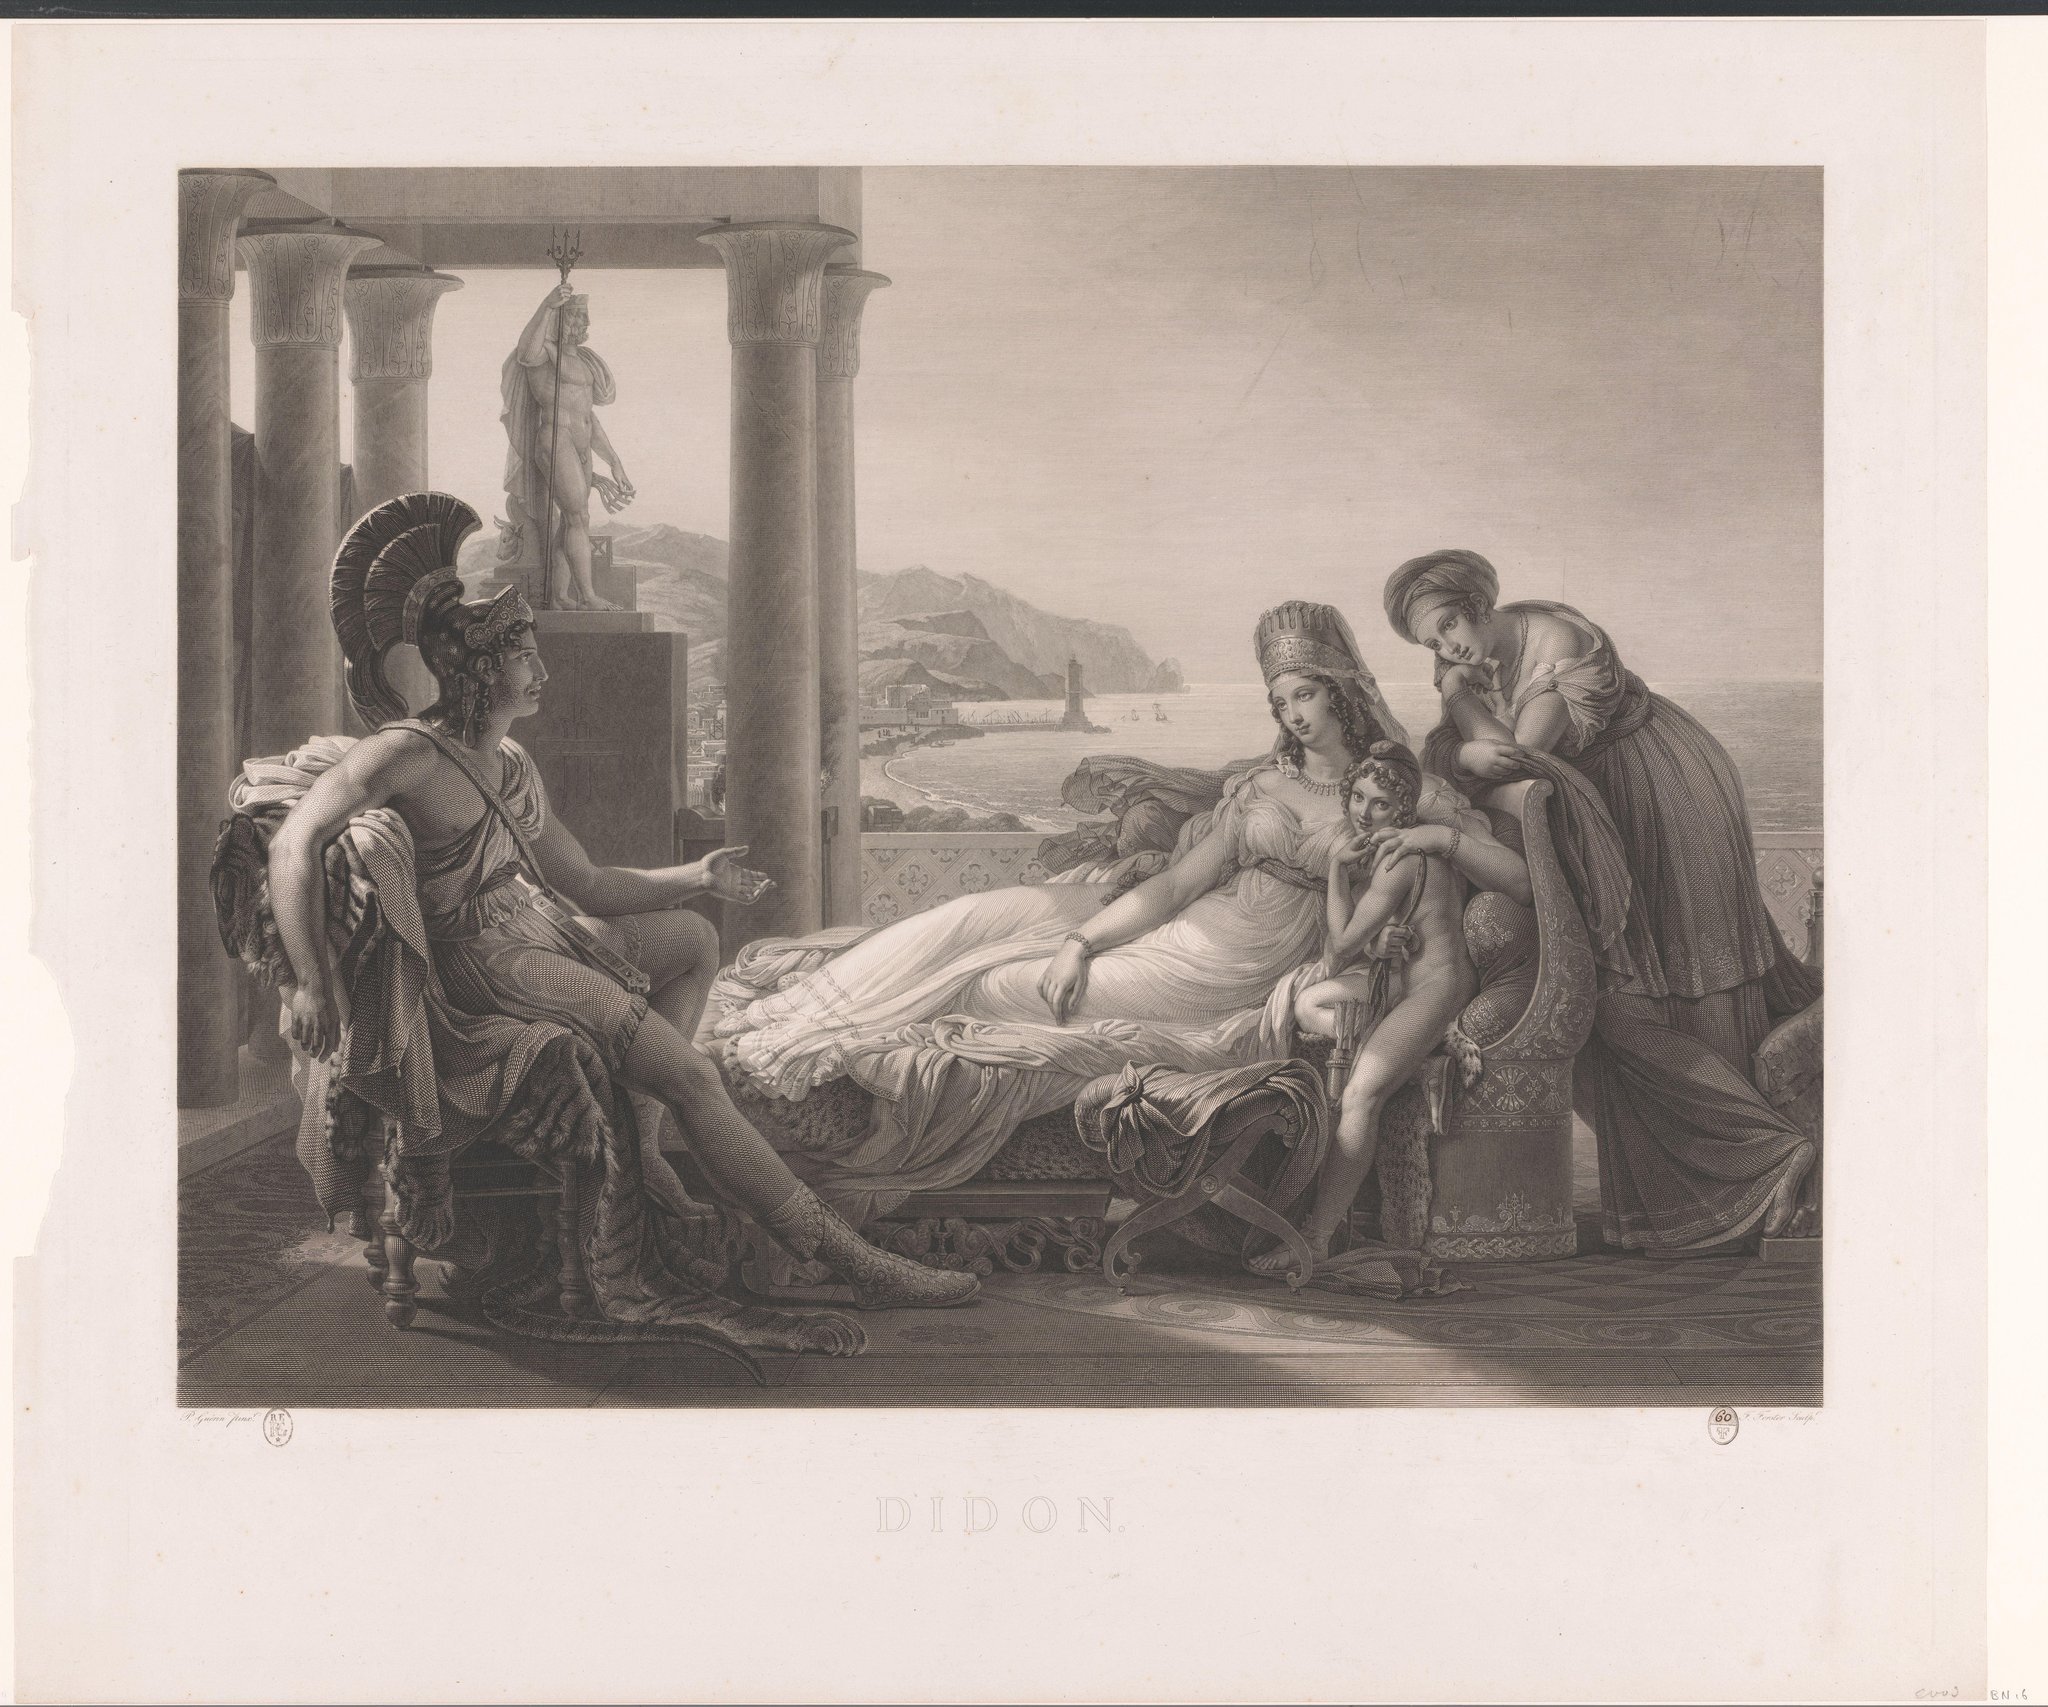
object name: print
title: Dido en Aeneas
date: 1828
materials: paper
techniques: engraving, etching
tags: (story of) dido, (story of) aeneas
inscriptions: collector's mark: Lugt 2203, collector's mark: ‘60’ Lugt 4188, collector's mark: Lugt 12